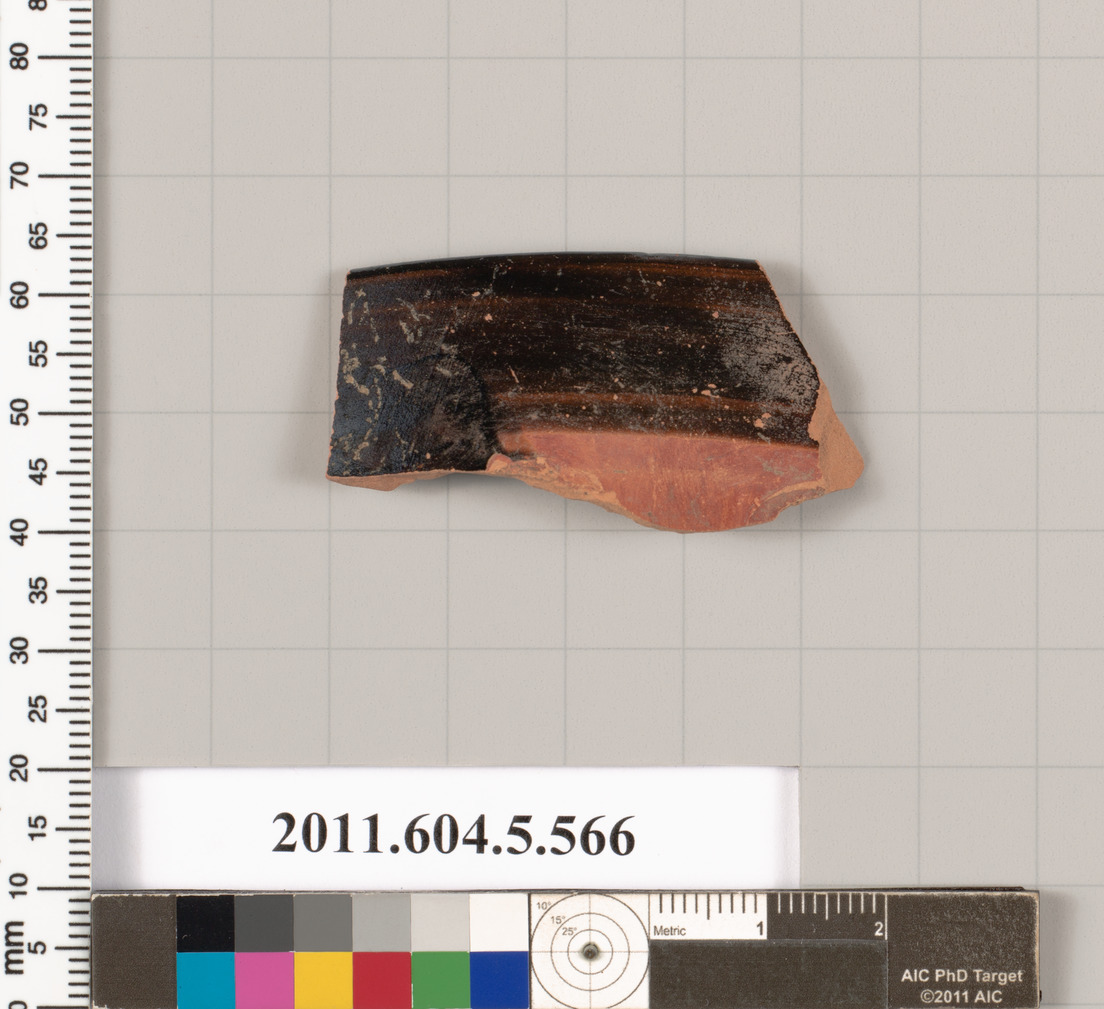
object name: kylix fragment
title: Terracotta rim fragment of a kylix (drinking cup)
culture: greek, attic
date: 600-401 BCE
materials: terracotta